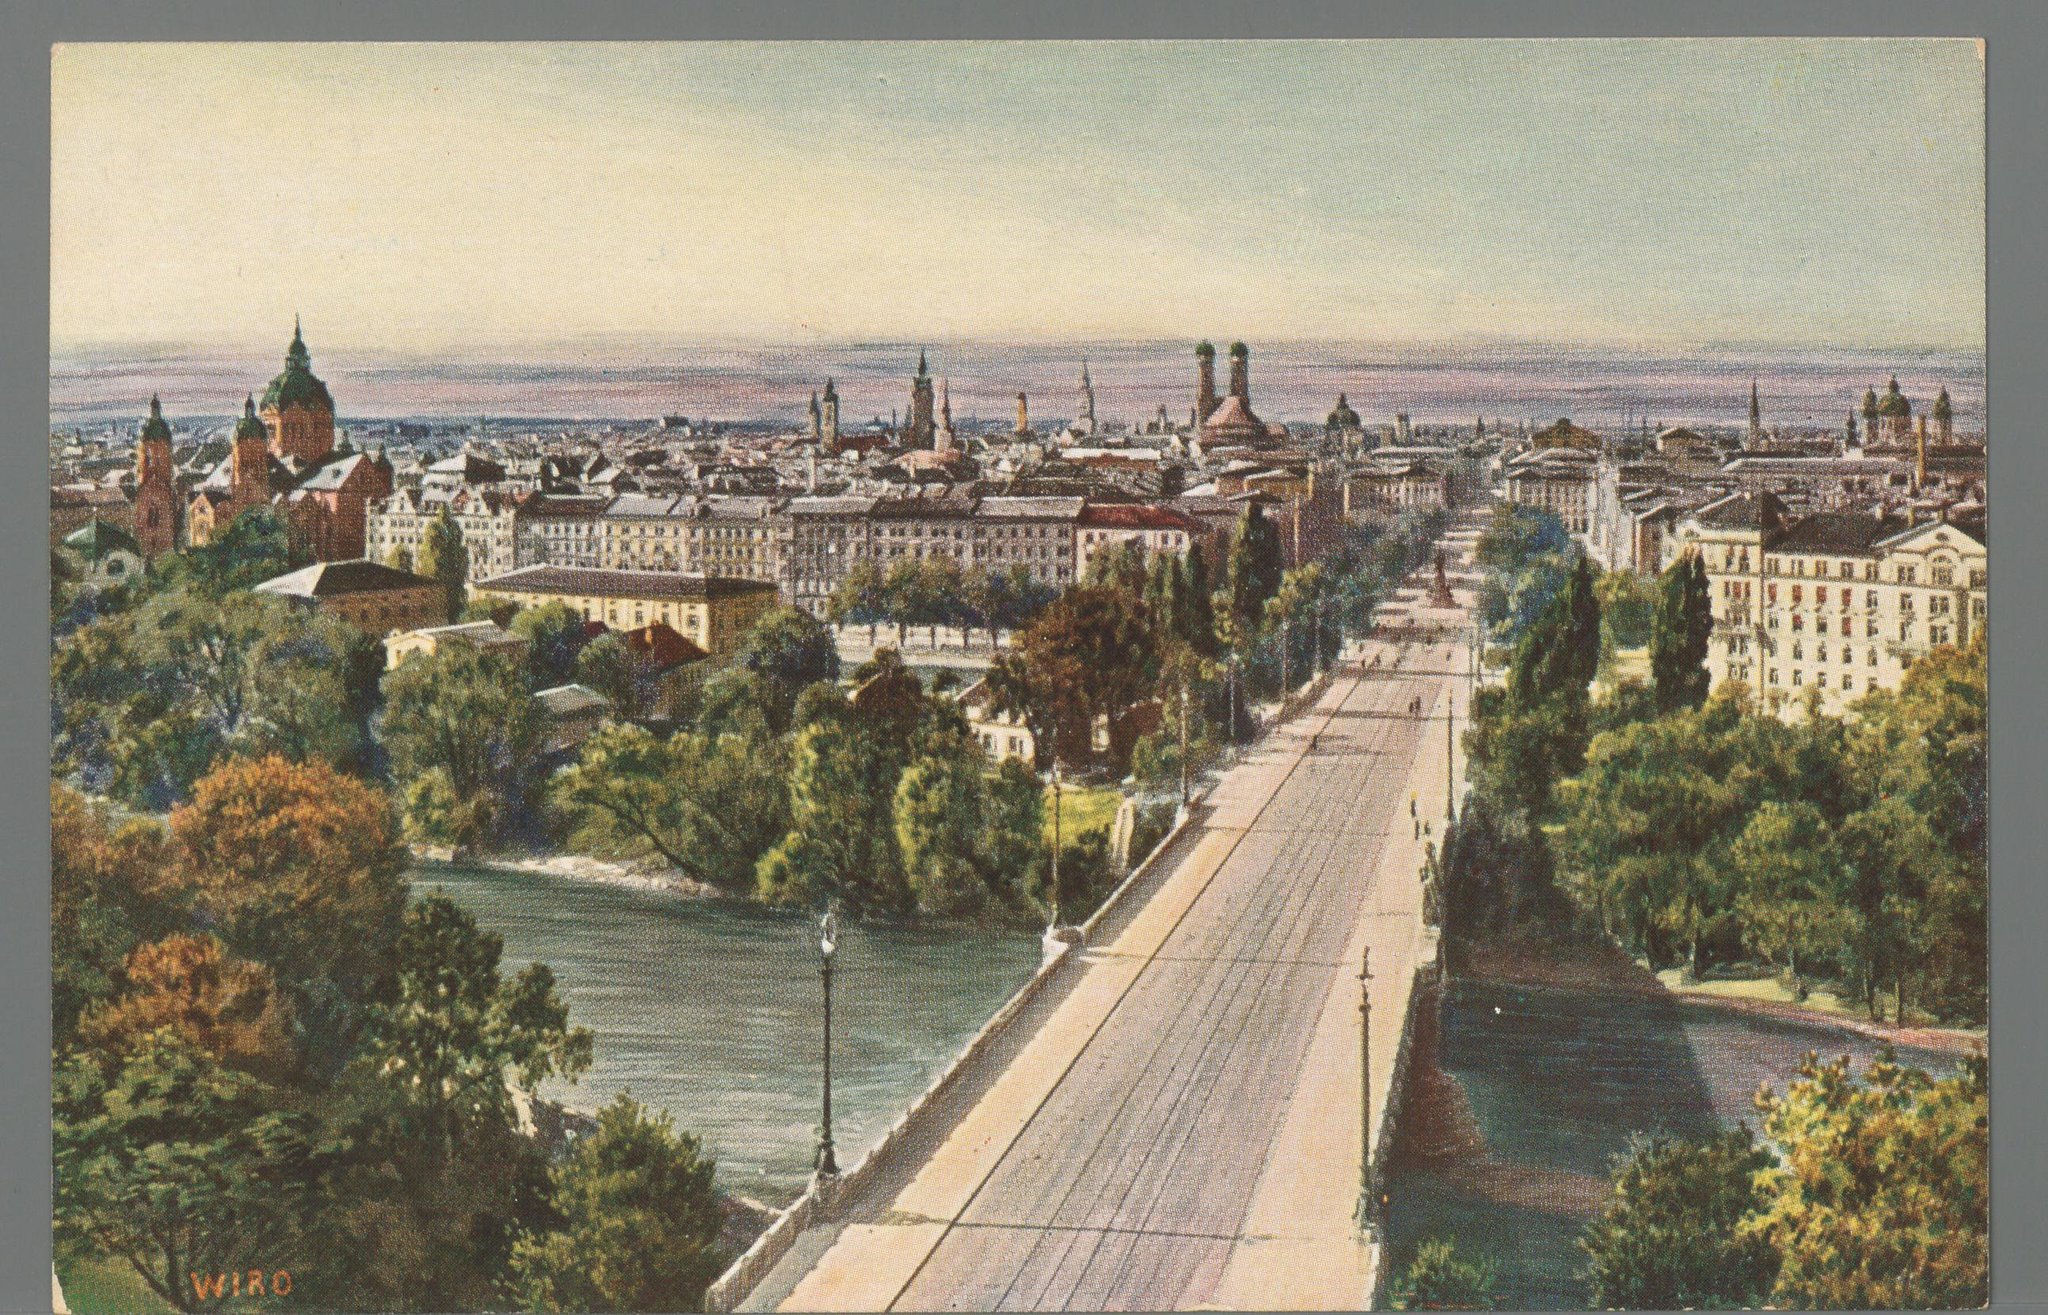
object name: reproduction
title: Künstler-Serie "WIRO" München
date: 1905-1930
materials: cardboard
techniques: color autotype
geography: munich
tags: city-view, and landscape with man-made constructions, canals, waters (in city), bridge in city across river, canal, etc.